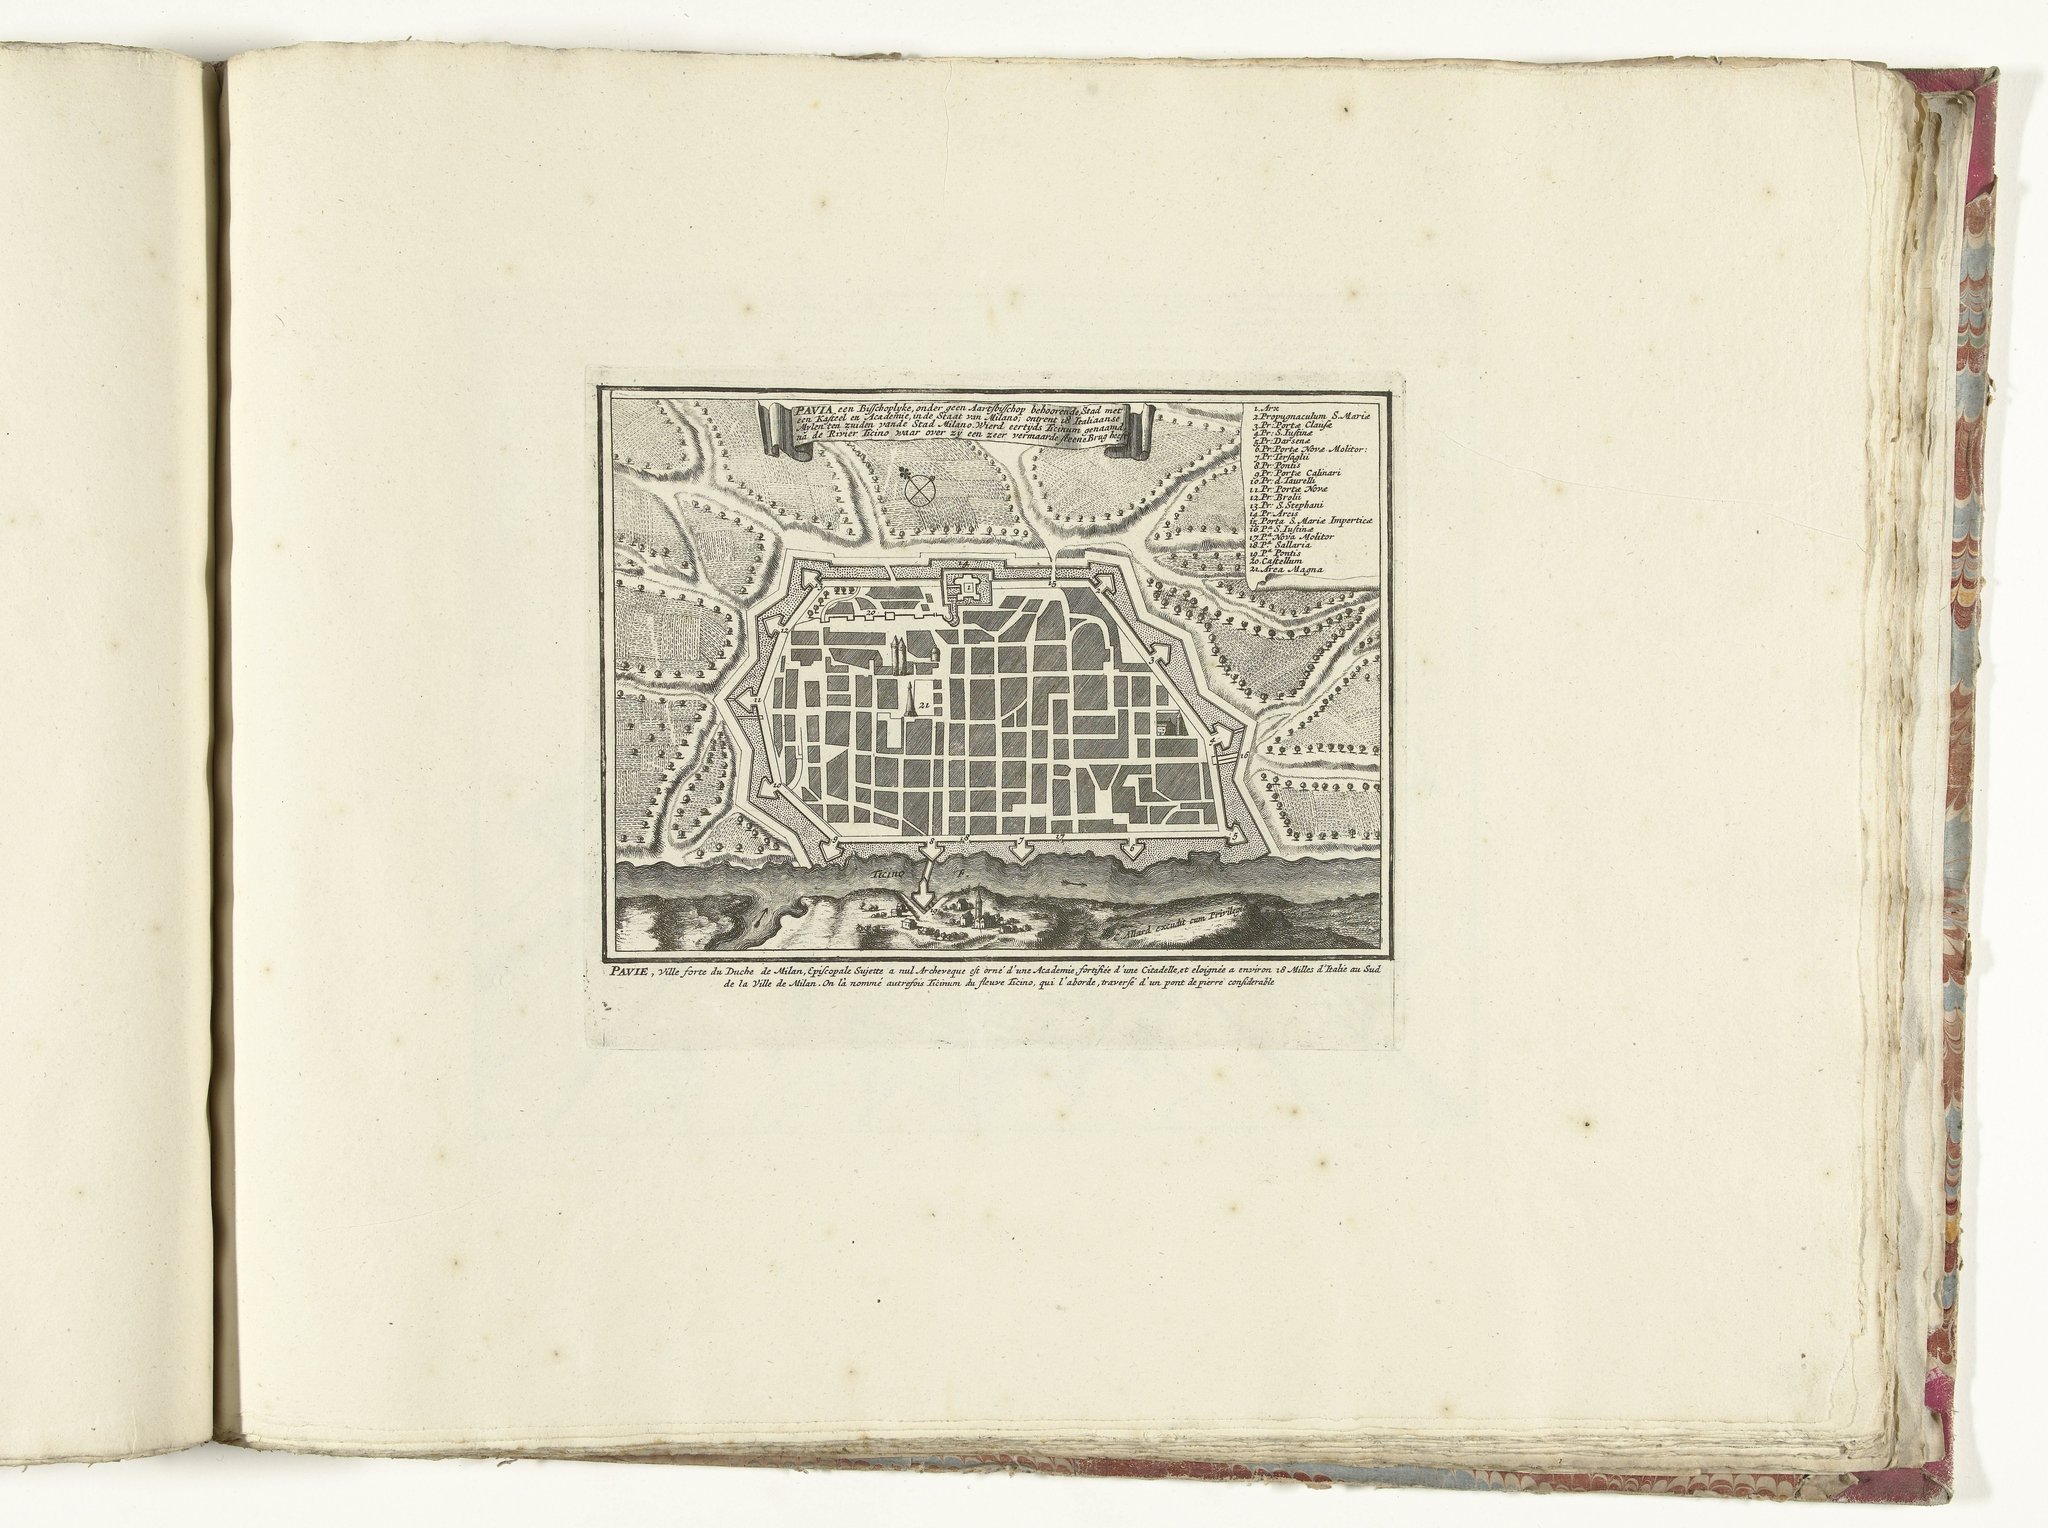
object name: print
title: Plattegrond van Pavia, ca. 1701-1713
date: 1701-1714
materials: paper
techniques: etching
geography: leiden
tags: maps of cities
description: Gekopieerd naar de Franse prenten in: Nicolas de Fer, Les forces de l'Europe, ou description des principales villes, avec leurs fortifications : dessignées par les meilleurs ingenieurs, particulierement celles ... de la France, dont les plans ont esté levez par M. de Vauban, Nicolas de Fer, Parijs 1693-1696, of andere voorbeelden.